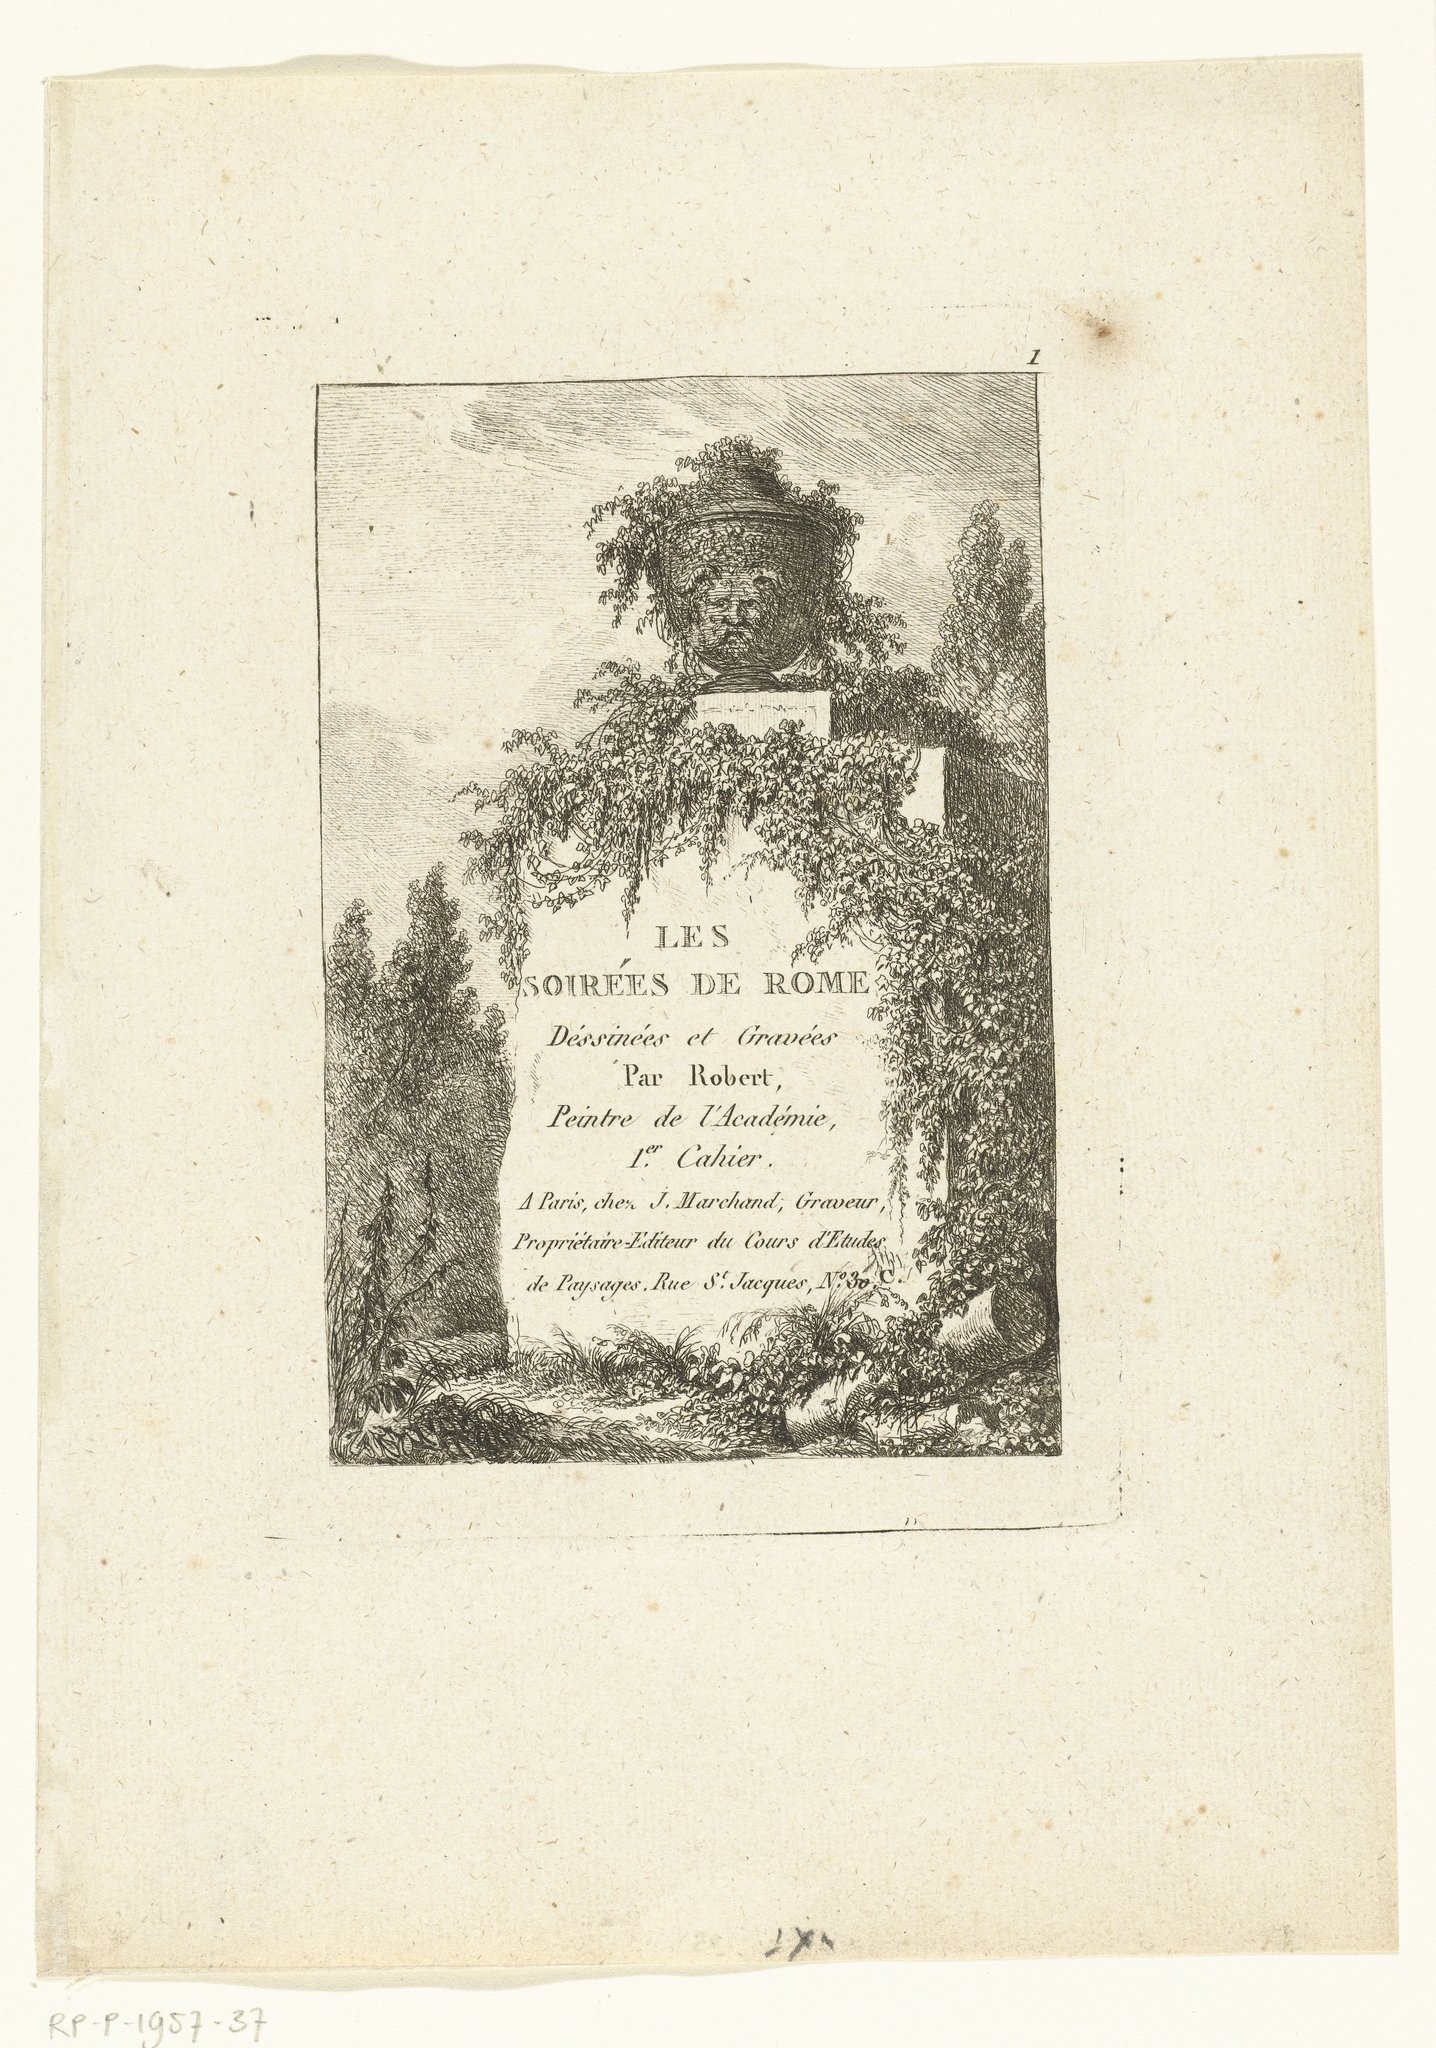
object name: titelprent, frontispice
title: Titelblad met een antieke vaas op een sokkel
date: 1763-1831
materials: paper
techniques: etching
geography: rome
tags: garden vase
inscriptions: collector's mark: ‘Douane Centrale La Portation Paris’, collector's mark: Lugt 2228, collector's mark: Lugt 2760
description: Een vaas op een sokkel, met de titel van de serie, overgroeid met planten. Eerste prent uit een serie van tien.